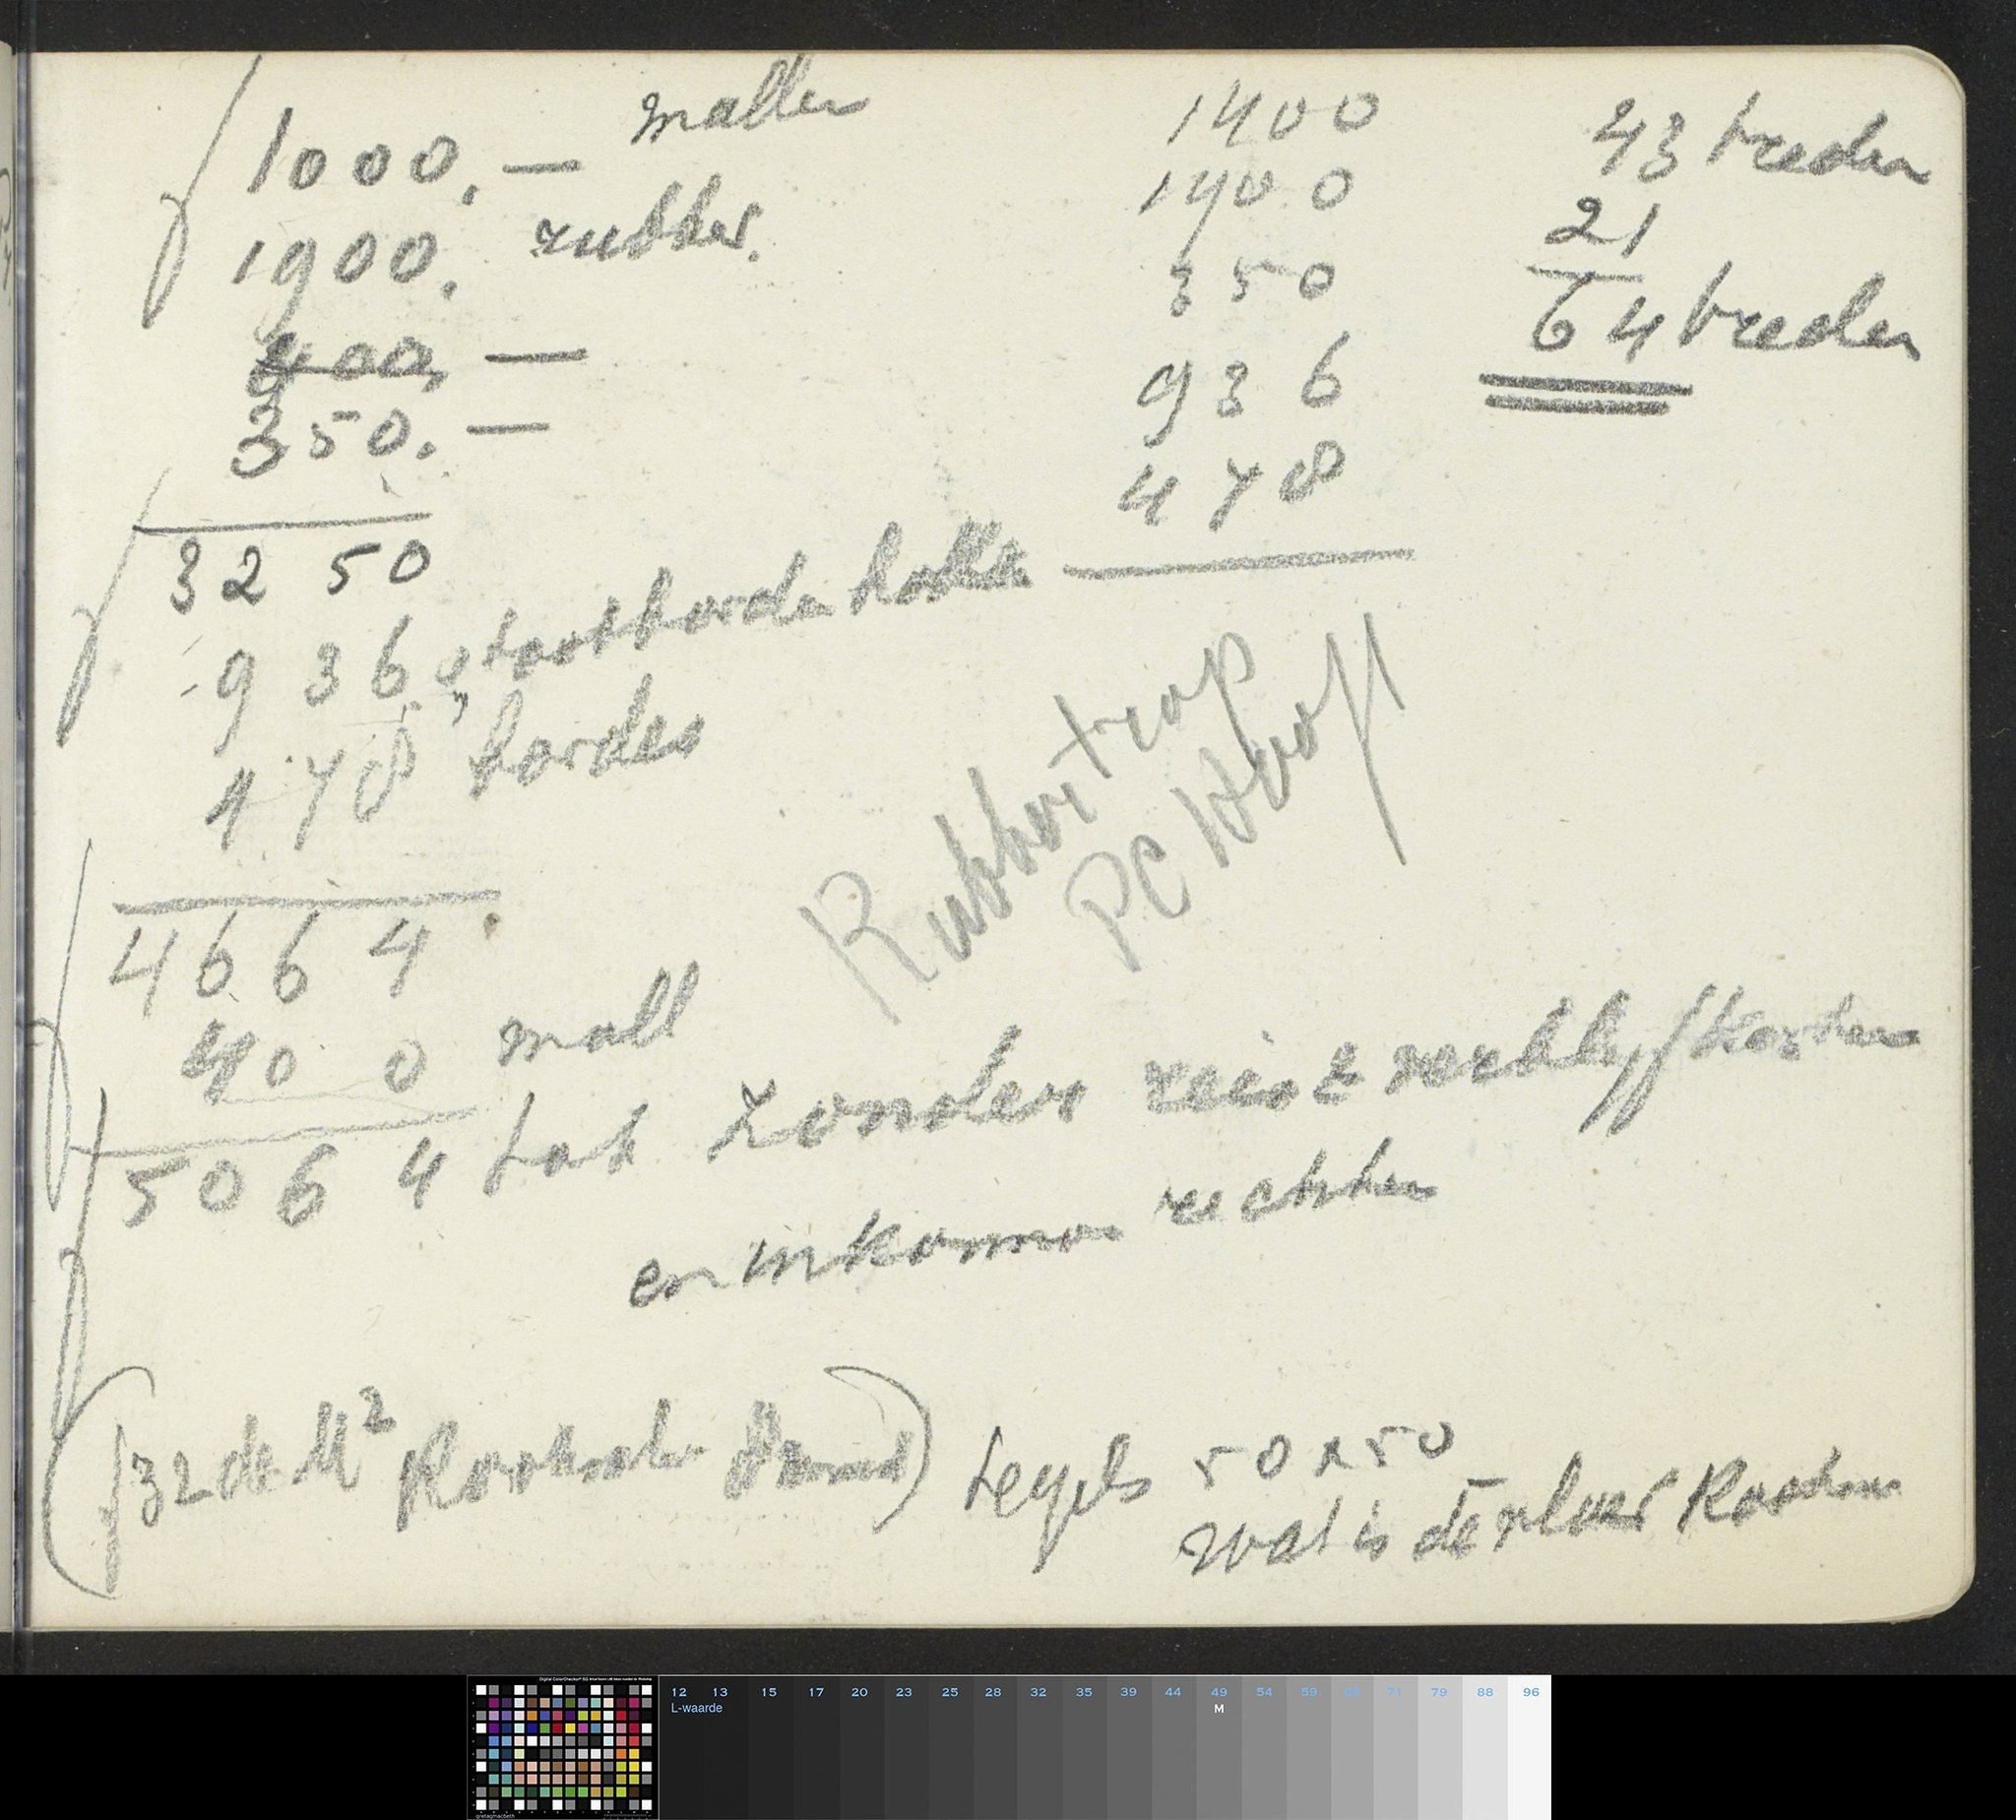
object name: sketchbook leaf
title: Notities en berekeningen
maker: carel adolph lion cachet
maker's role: draughtsman, print maker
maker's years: 1864-1945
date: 1928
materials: paper, pencil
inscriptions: annotation: ‘[...]’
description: Blad 12 recto uit een schetsboek met 24 bladen.